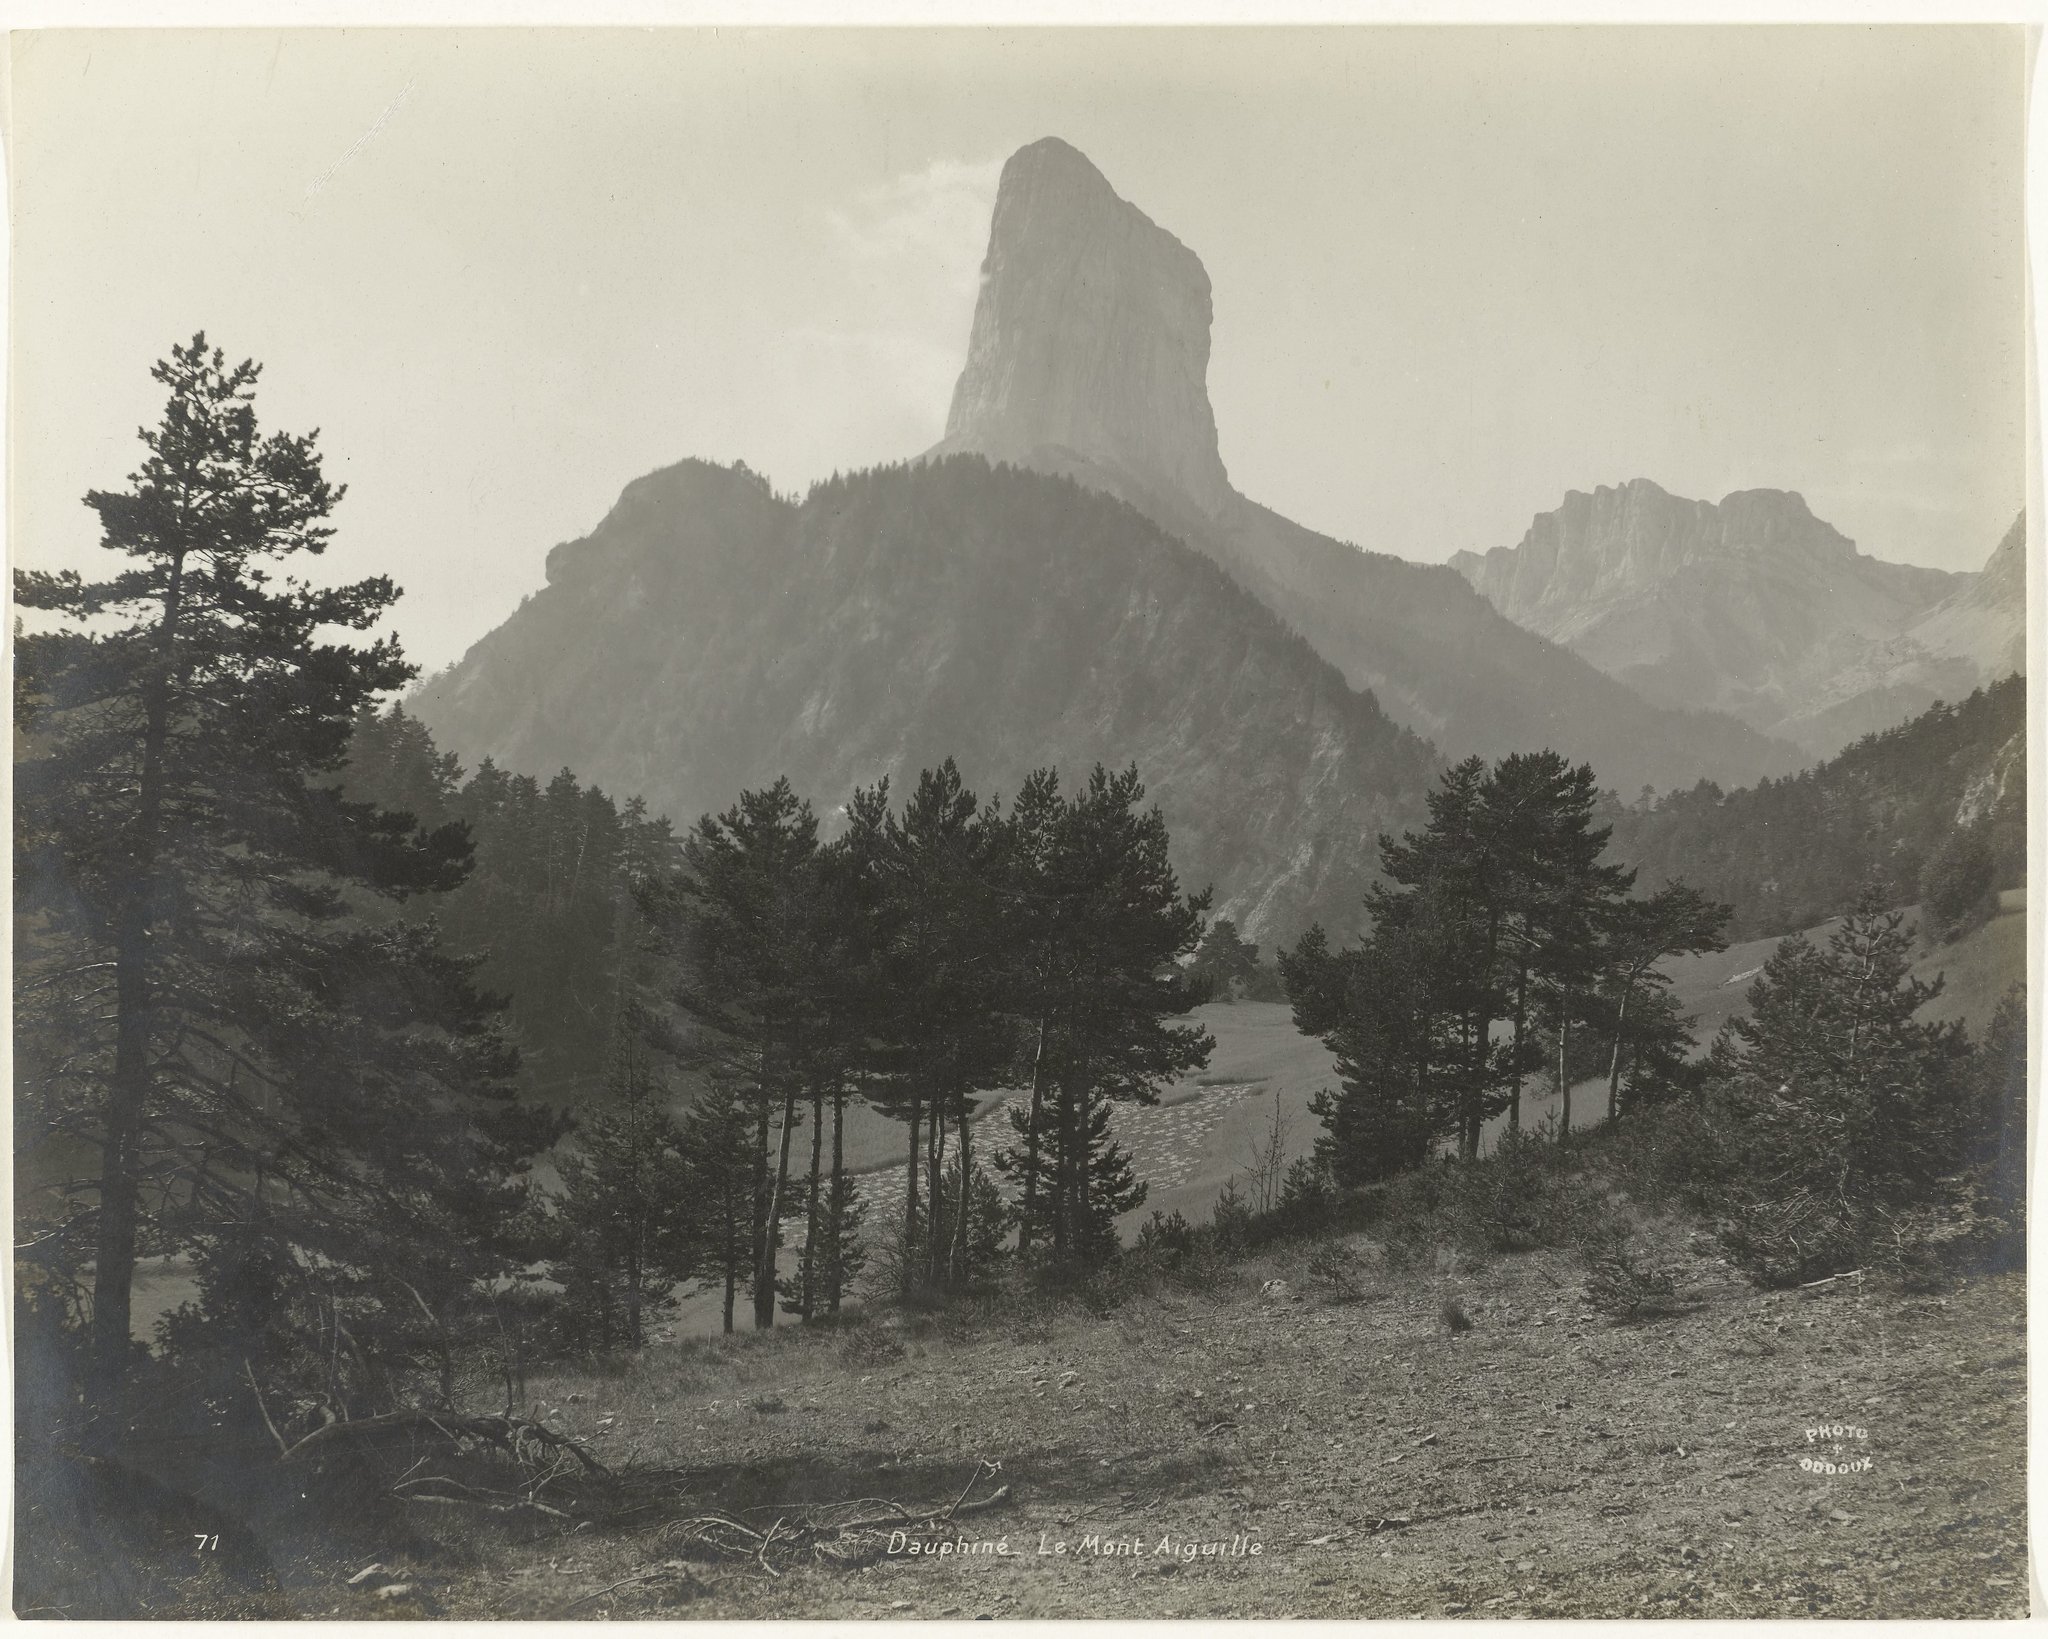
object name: photograph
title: Gezicht op de Mont Aiguille nabij Grenoble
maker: gustave oddoux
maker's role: fotograaf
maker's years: 1869-1954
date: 1910-1940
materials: paper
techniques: gelatin silver print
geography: grenoble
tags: mountains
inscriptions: number: ‘71’